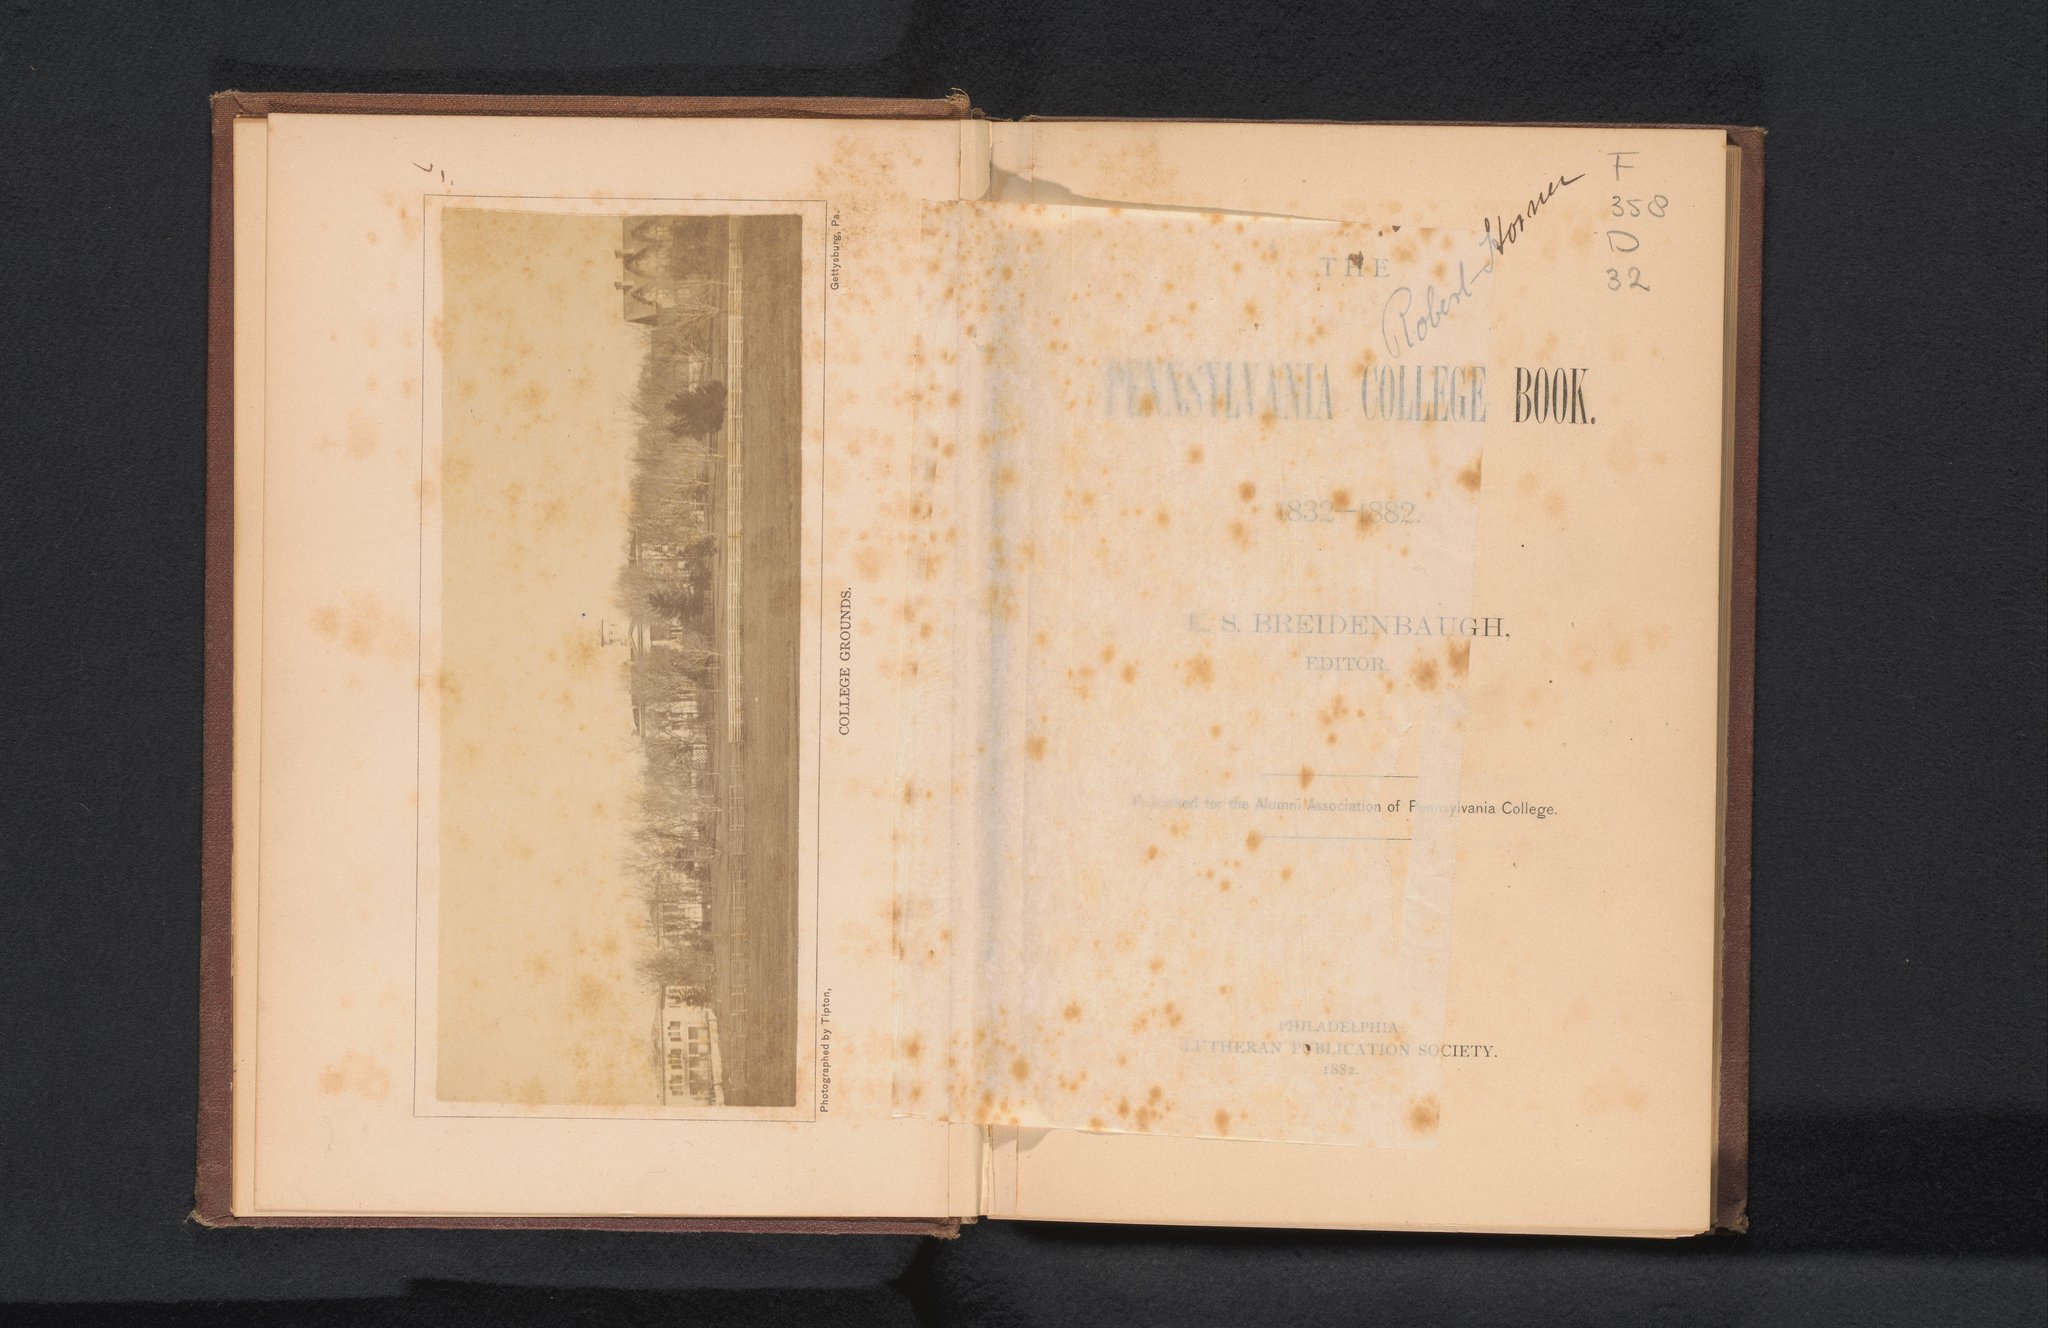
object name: photograph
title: College grounds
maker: william h. tipton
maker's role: fotograaf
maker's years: 1850-1920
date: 1877-1882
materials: photographic support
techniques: albumen print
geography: gettysburg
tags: university building, college